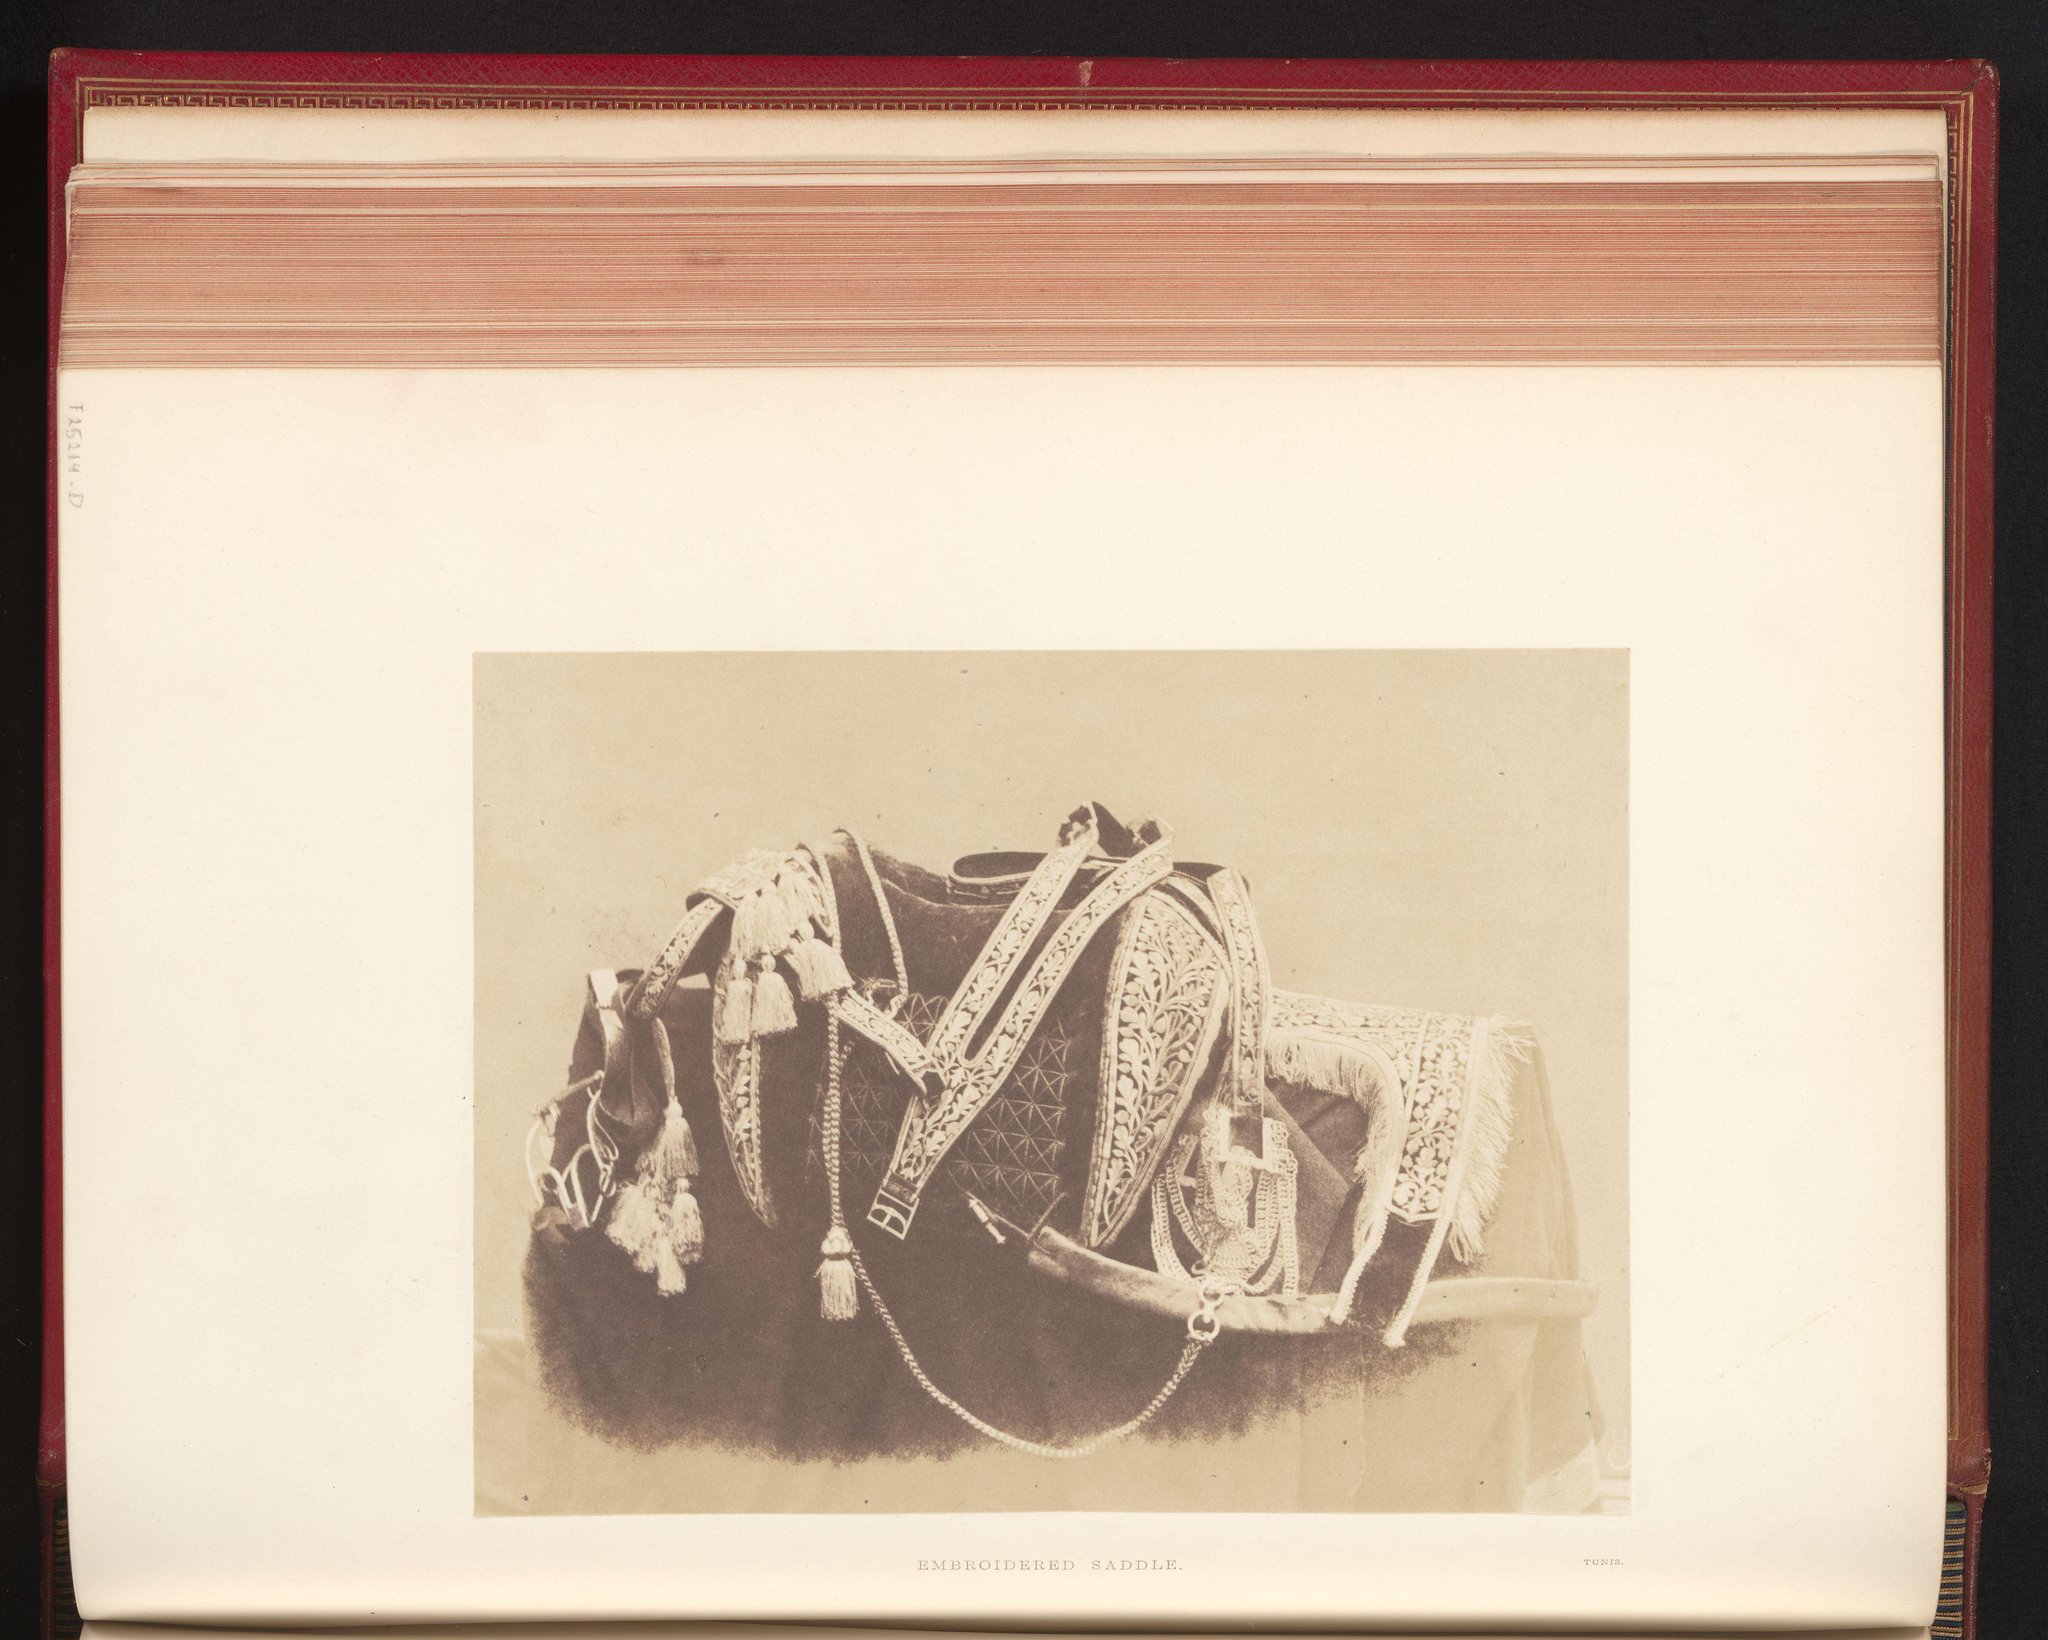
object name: page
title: Embroidered Saddle. Tunis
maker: hugh owen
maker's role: fotograaf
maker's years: 1808-1897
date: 1851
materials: photographic support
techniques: salted paper print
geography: london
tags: saddle, london